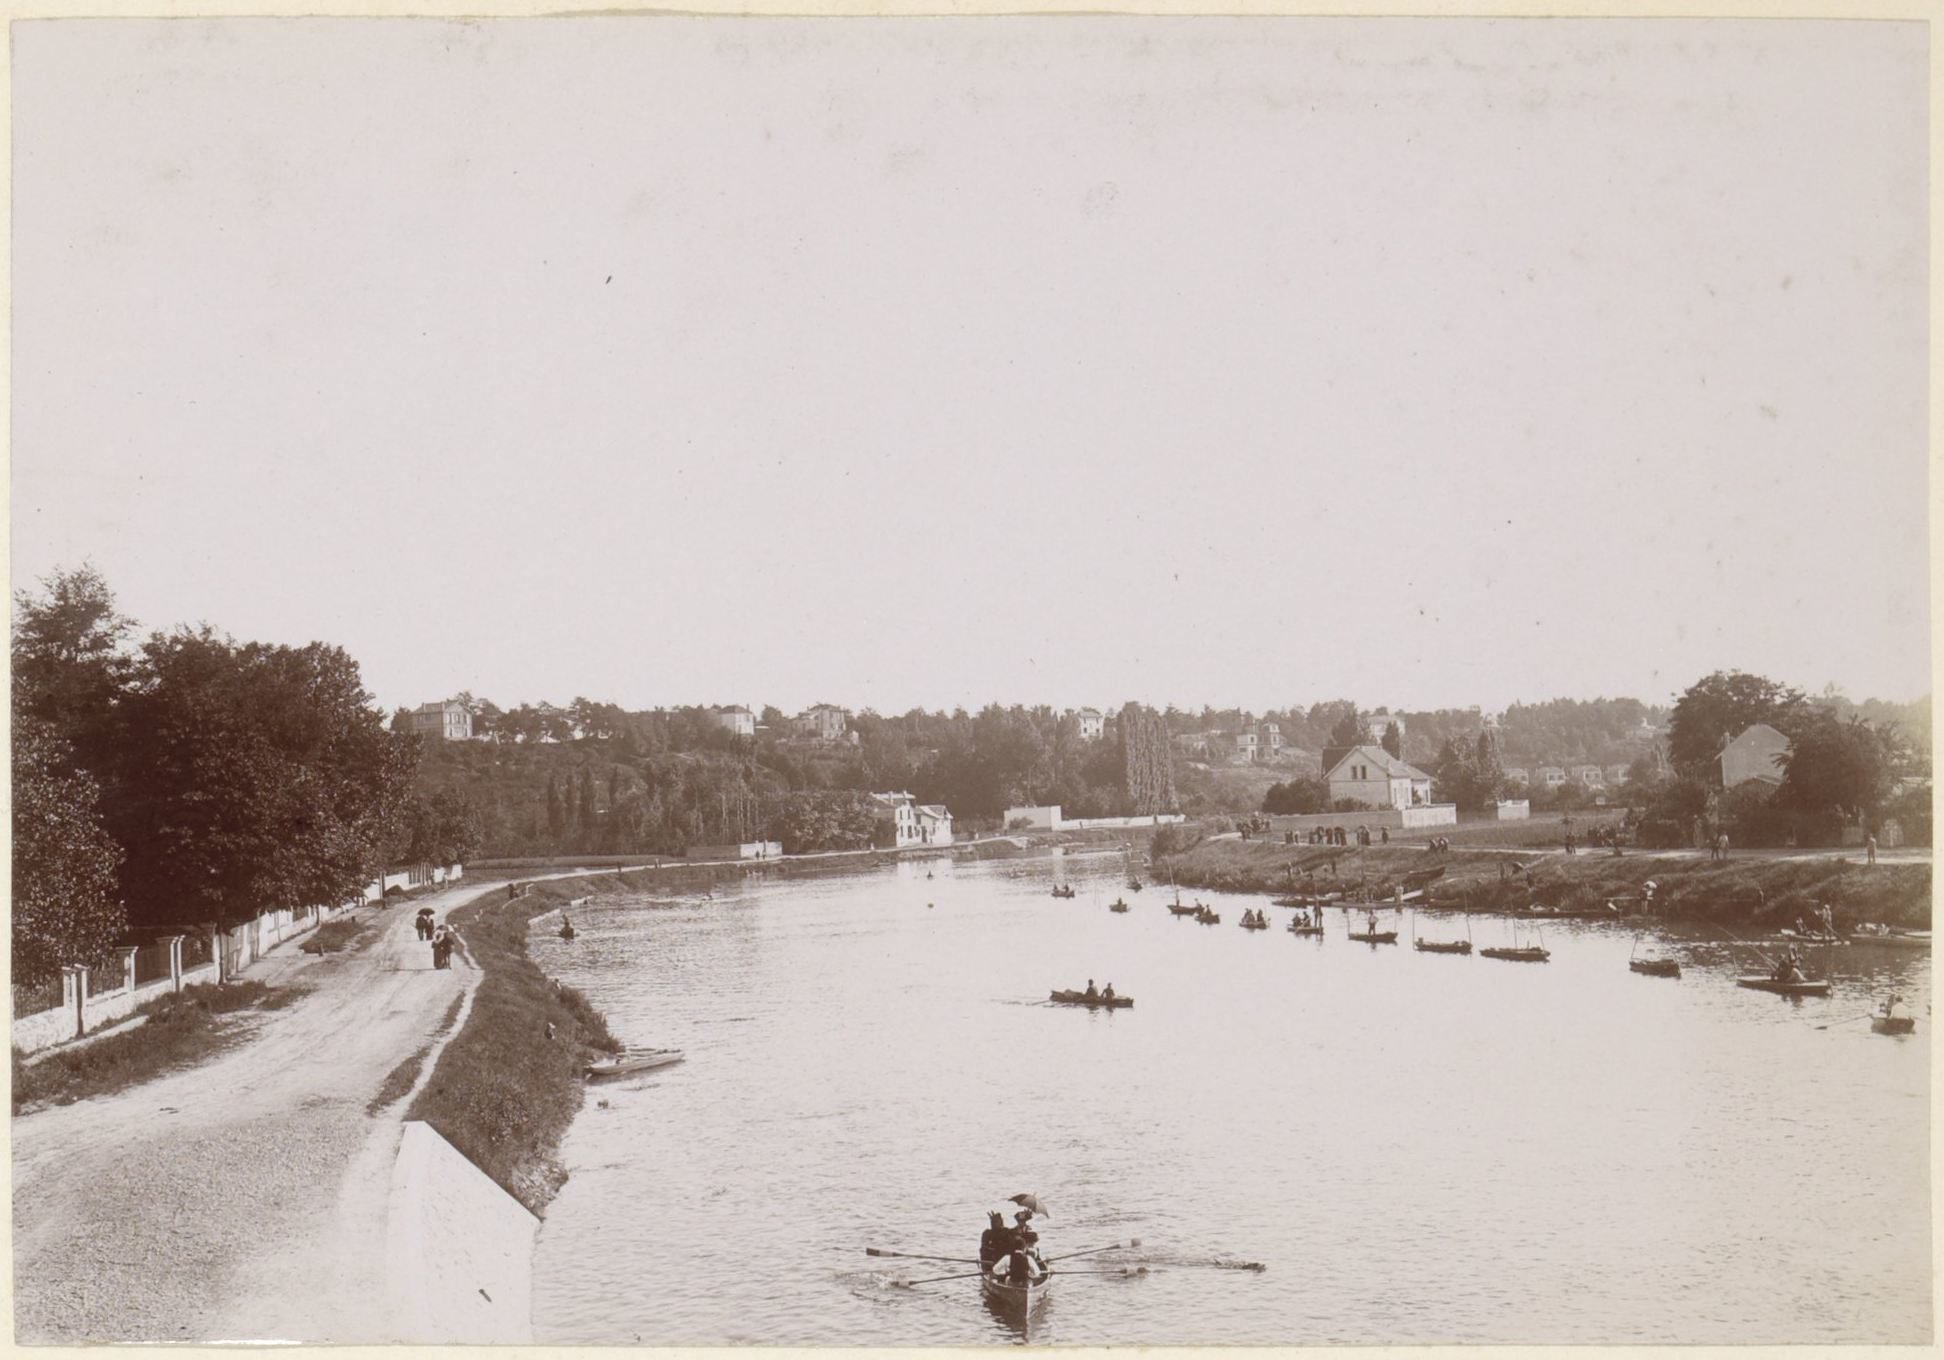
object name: photograph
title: Gezicht op een rivier met boten, vermoedelijk in Frankrijk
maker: Anonymous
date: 1900-1910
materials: paper, photographic support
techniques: daylight paper print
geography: france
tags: prospect of village, silhouette of village, river bank, rowing-boat, canoe, etc., river (+ landscape with figures, staffage), france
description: Onderdeel van Fotoalbum van een Franse amateurfotograaf met opnames van een familie, distilleerderij Delizy & Doistau Fils, het leger en bezienswaardigheden in Frankrijk.